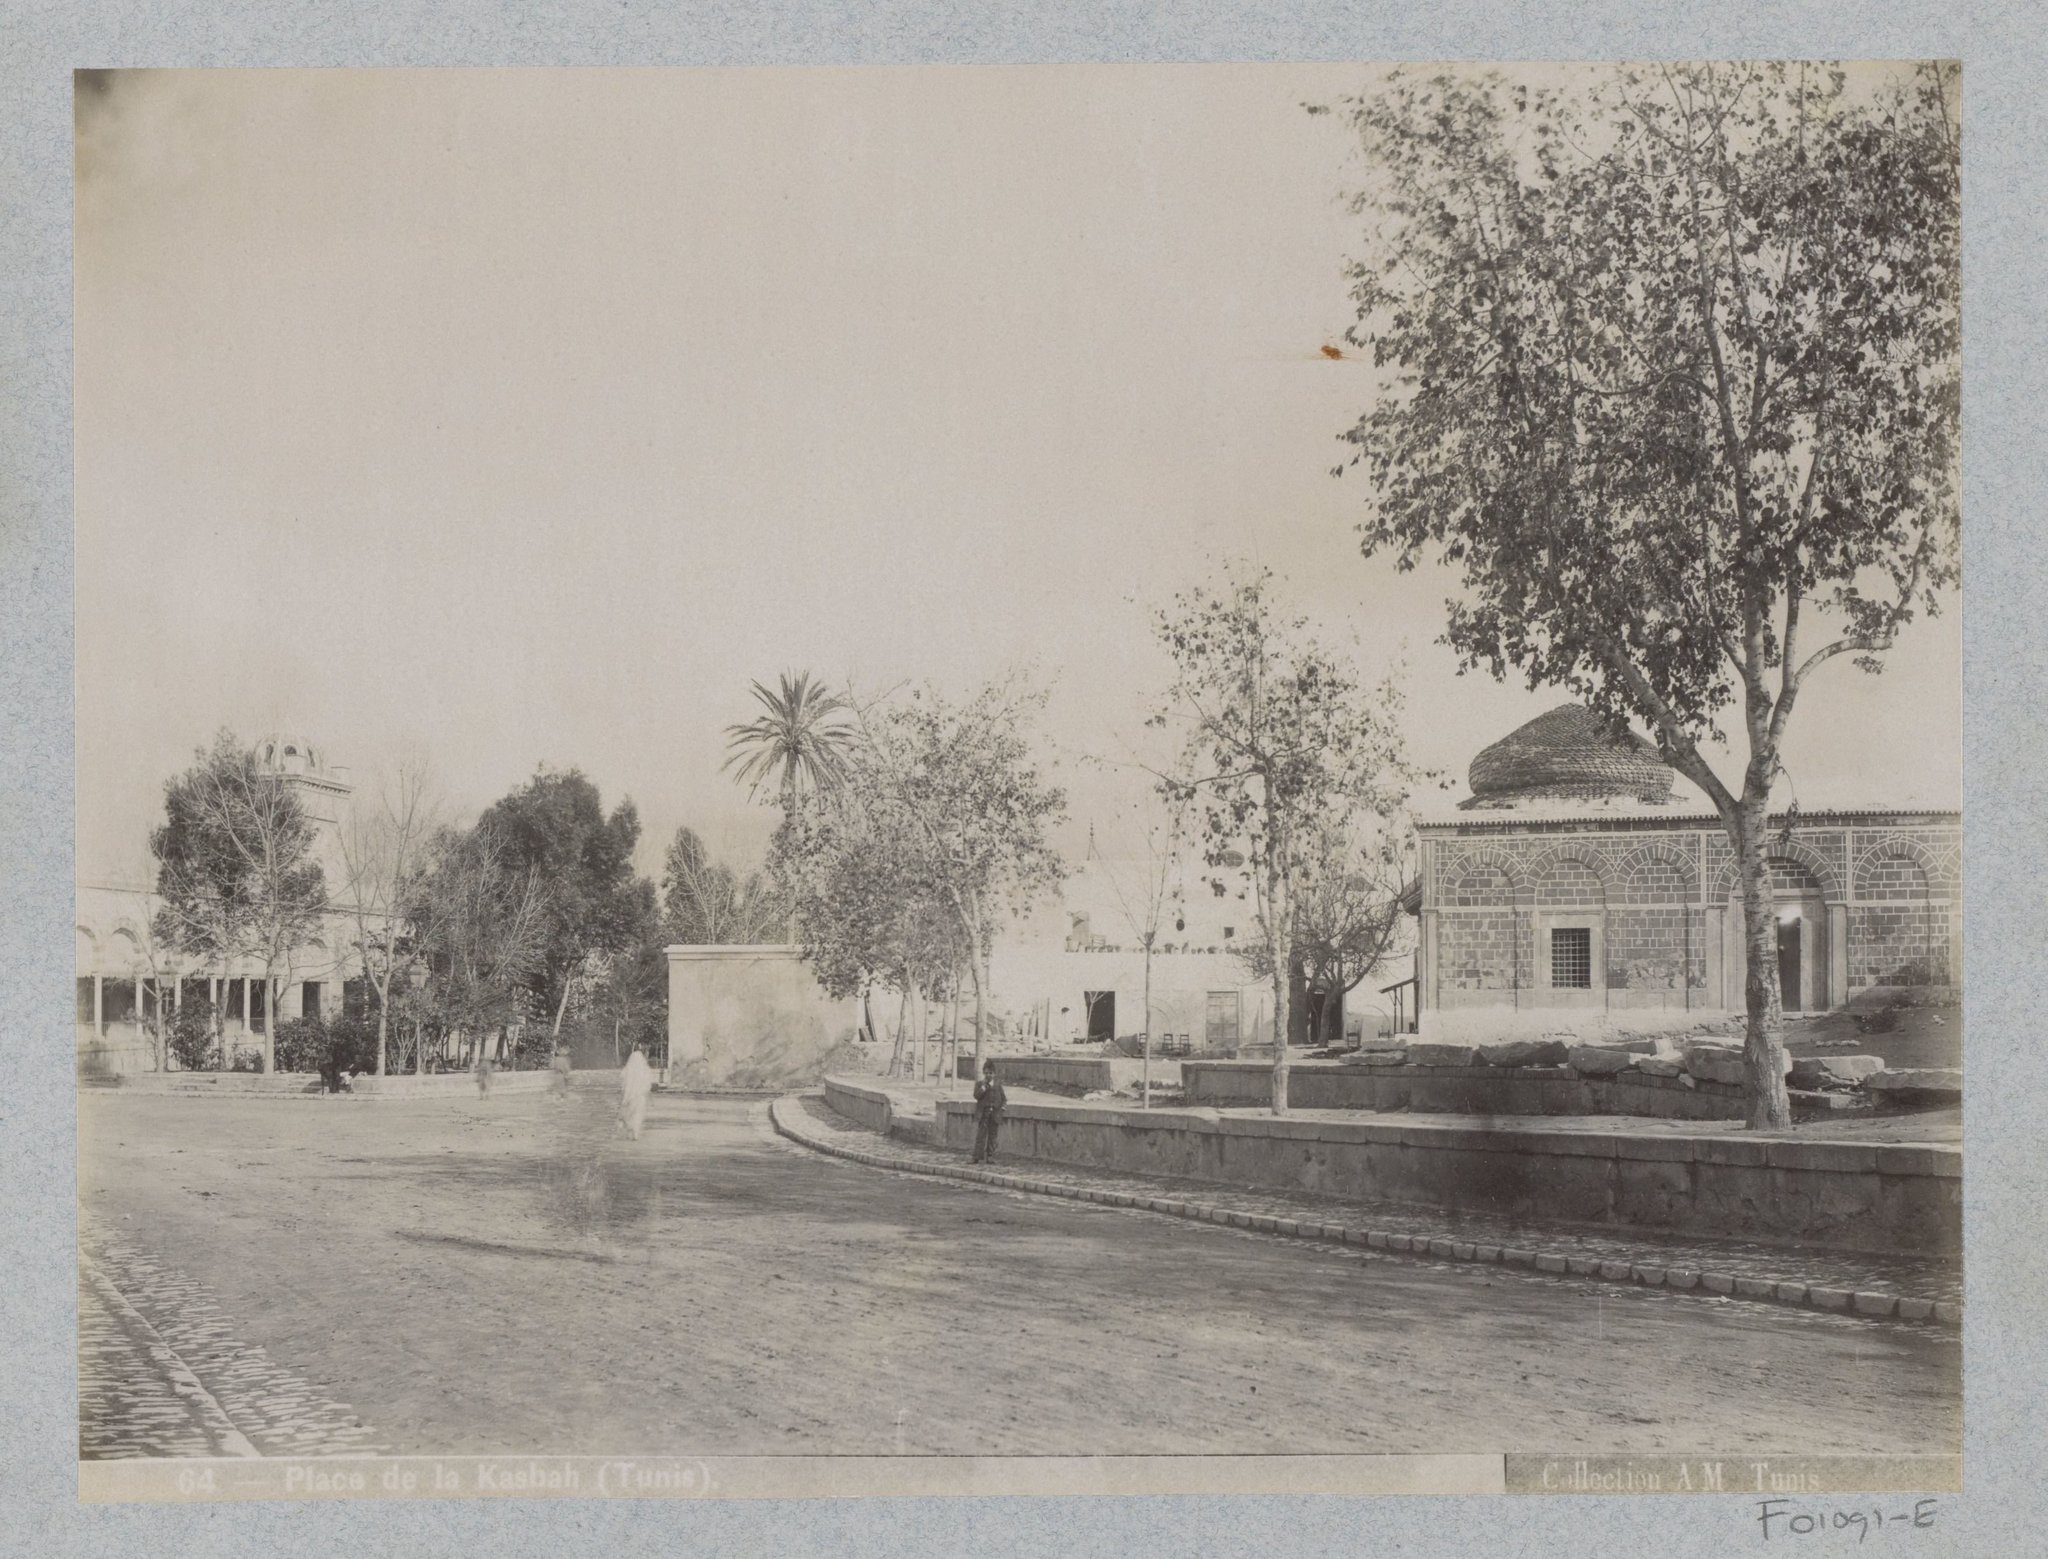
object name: photograph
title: Place de la Kasbah (Tunis)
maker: am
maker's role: fotograaf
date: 1880-1900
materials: paper, photographic support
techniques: albumen print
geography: tunis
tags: square, place, circus, etc. (+ city(-scape) with figures, staffage), street (+ city(-scape) with figures, staffage)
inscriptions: negative number: ‘64’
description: Onderdeel van Reisalbum met foto's van bezienswaardigheden in Tunis en Tunesië.